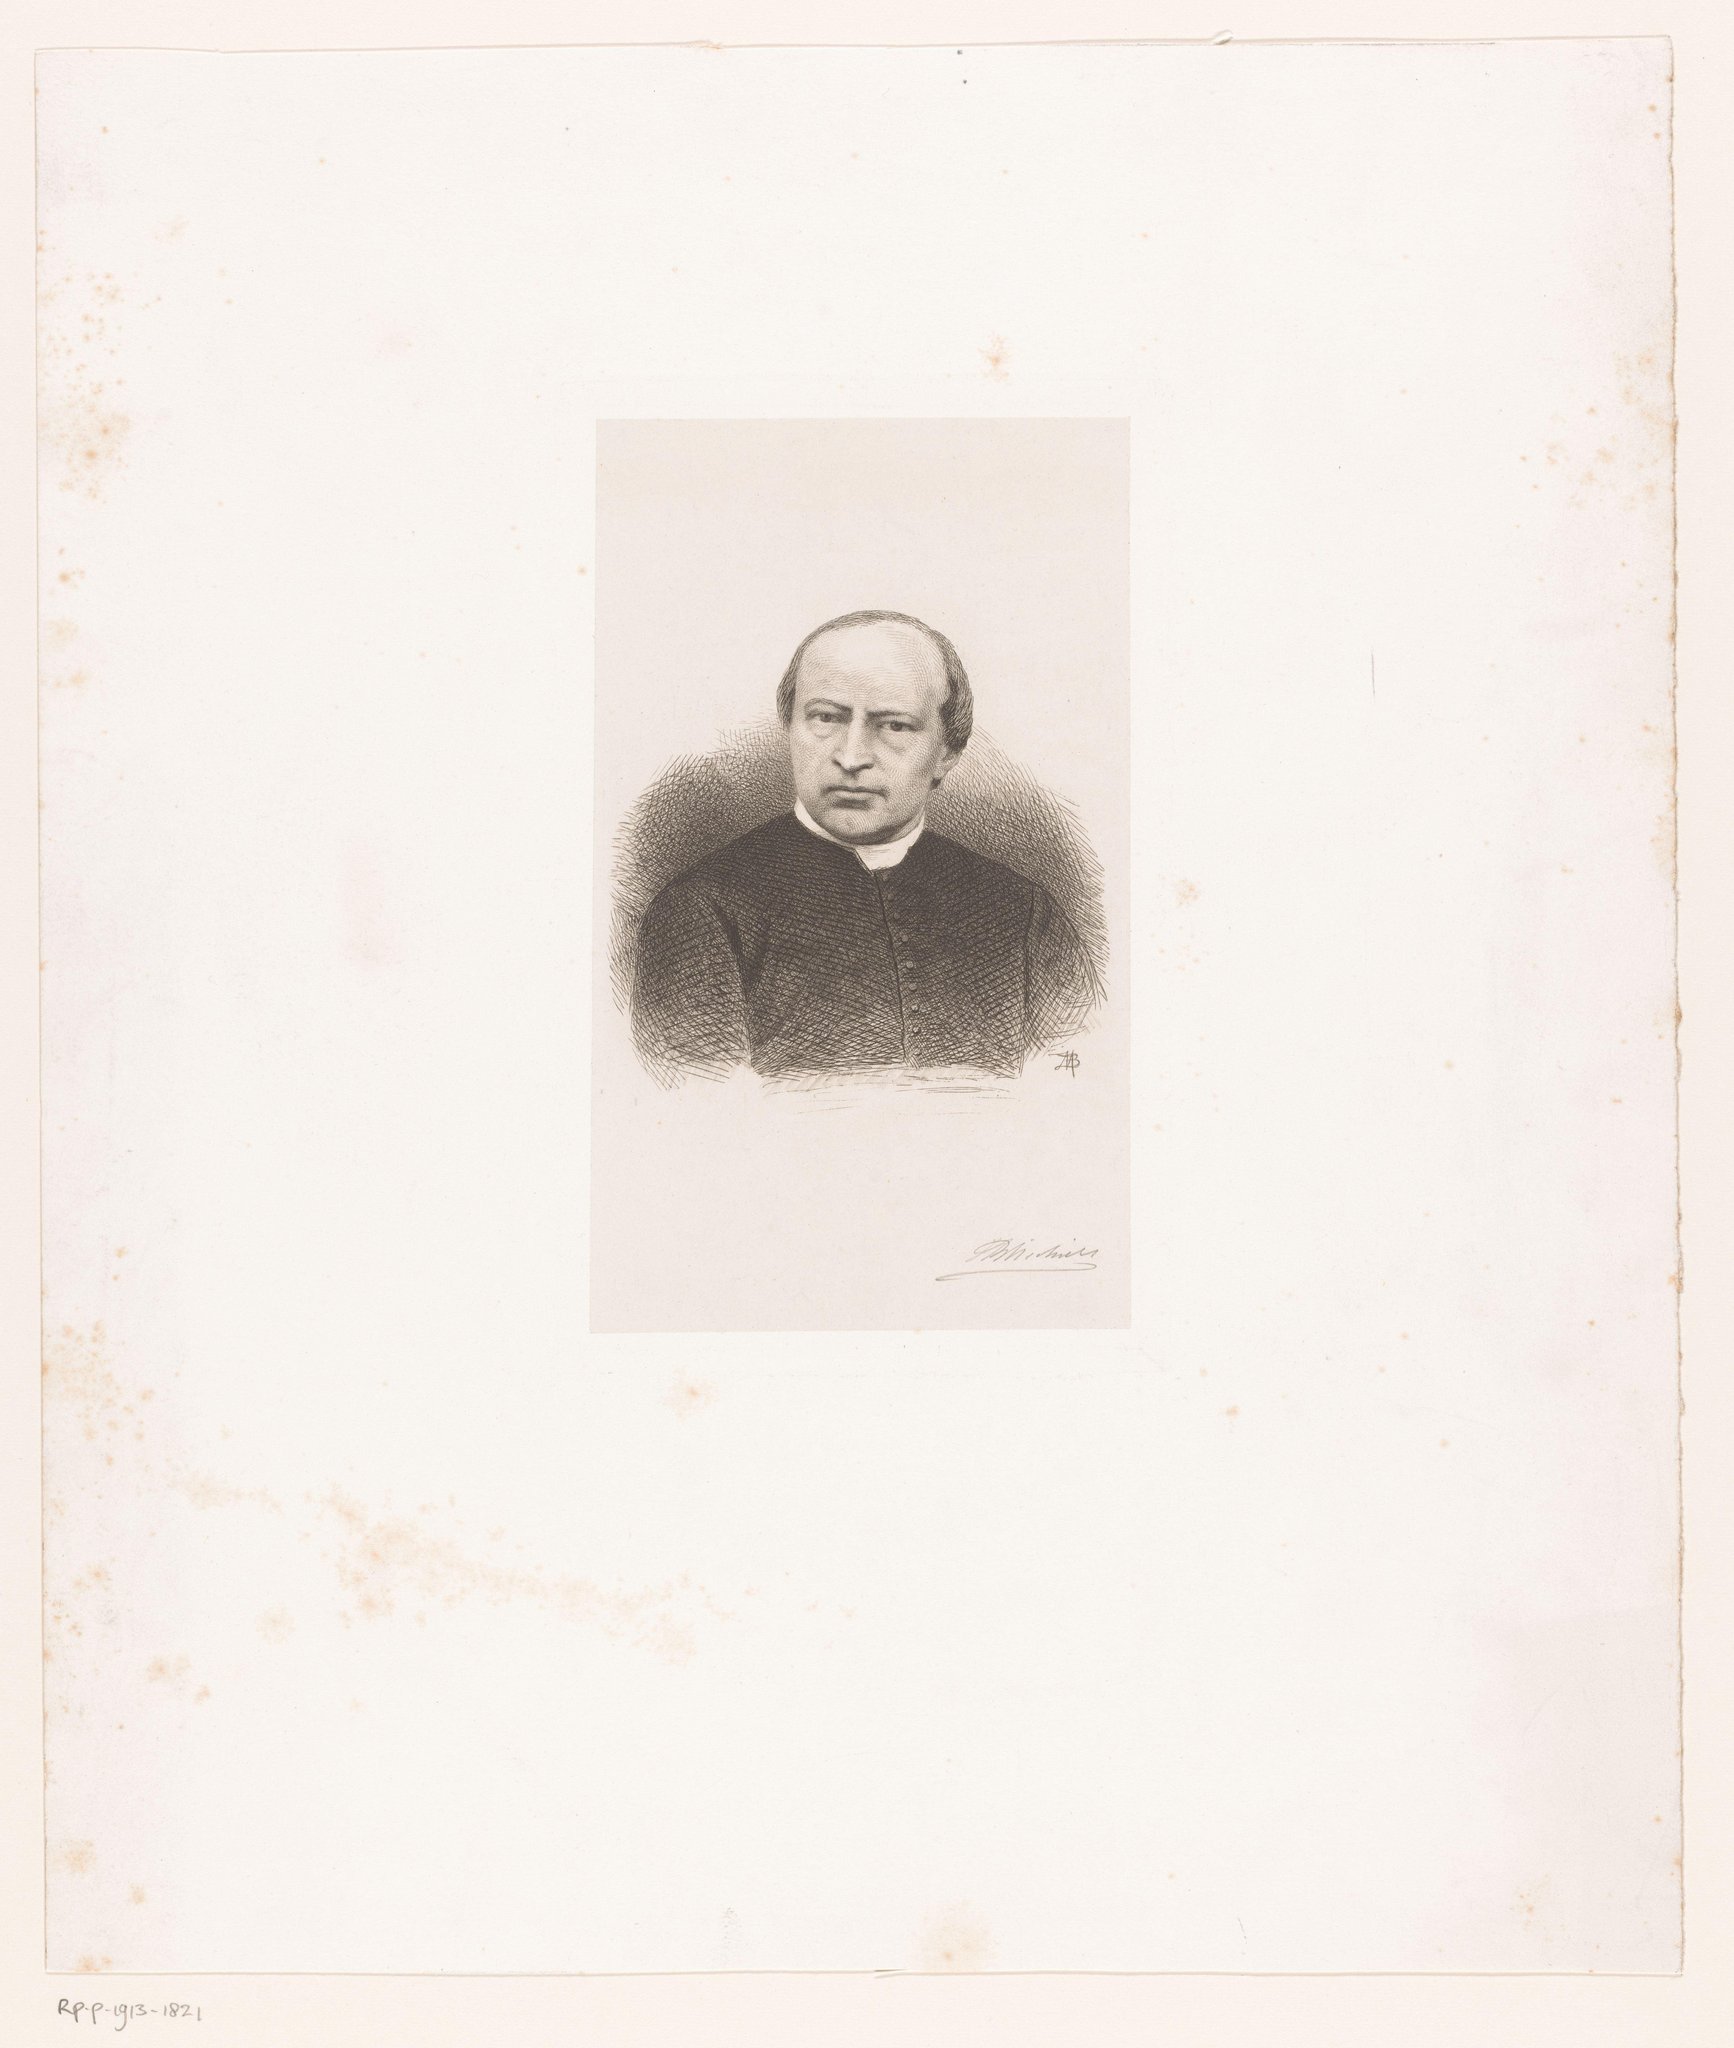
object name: print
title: Portret van L. Thijs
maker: jean baptiste pierre michiels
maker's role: print maker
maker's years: 1821-1890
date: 1831-1890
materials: paper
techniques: etching, roulette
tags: adult man, historical persons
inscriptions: collector's mark: Lugt 2228